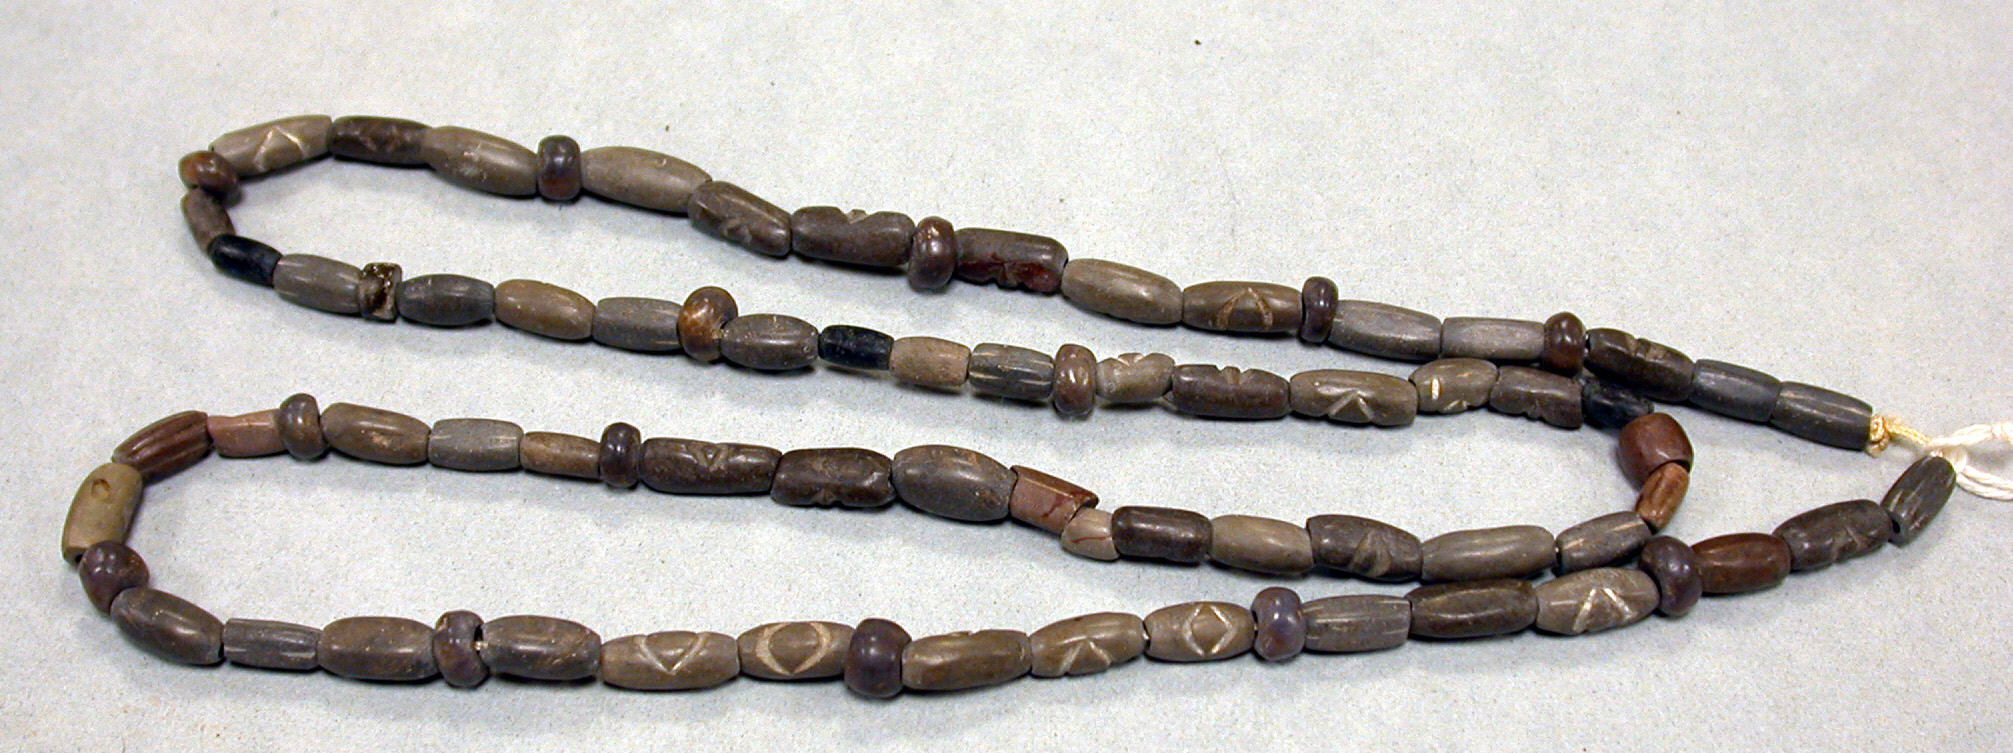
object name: bead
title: Necklace of Stone Beads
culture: peruvian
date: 1-1566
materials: stone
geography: peru